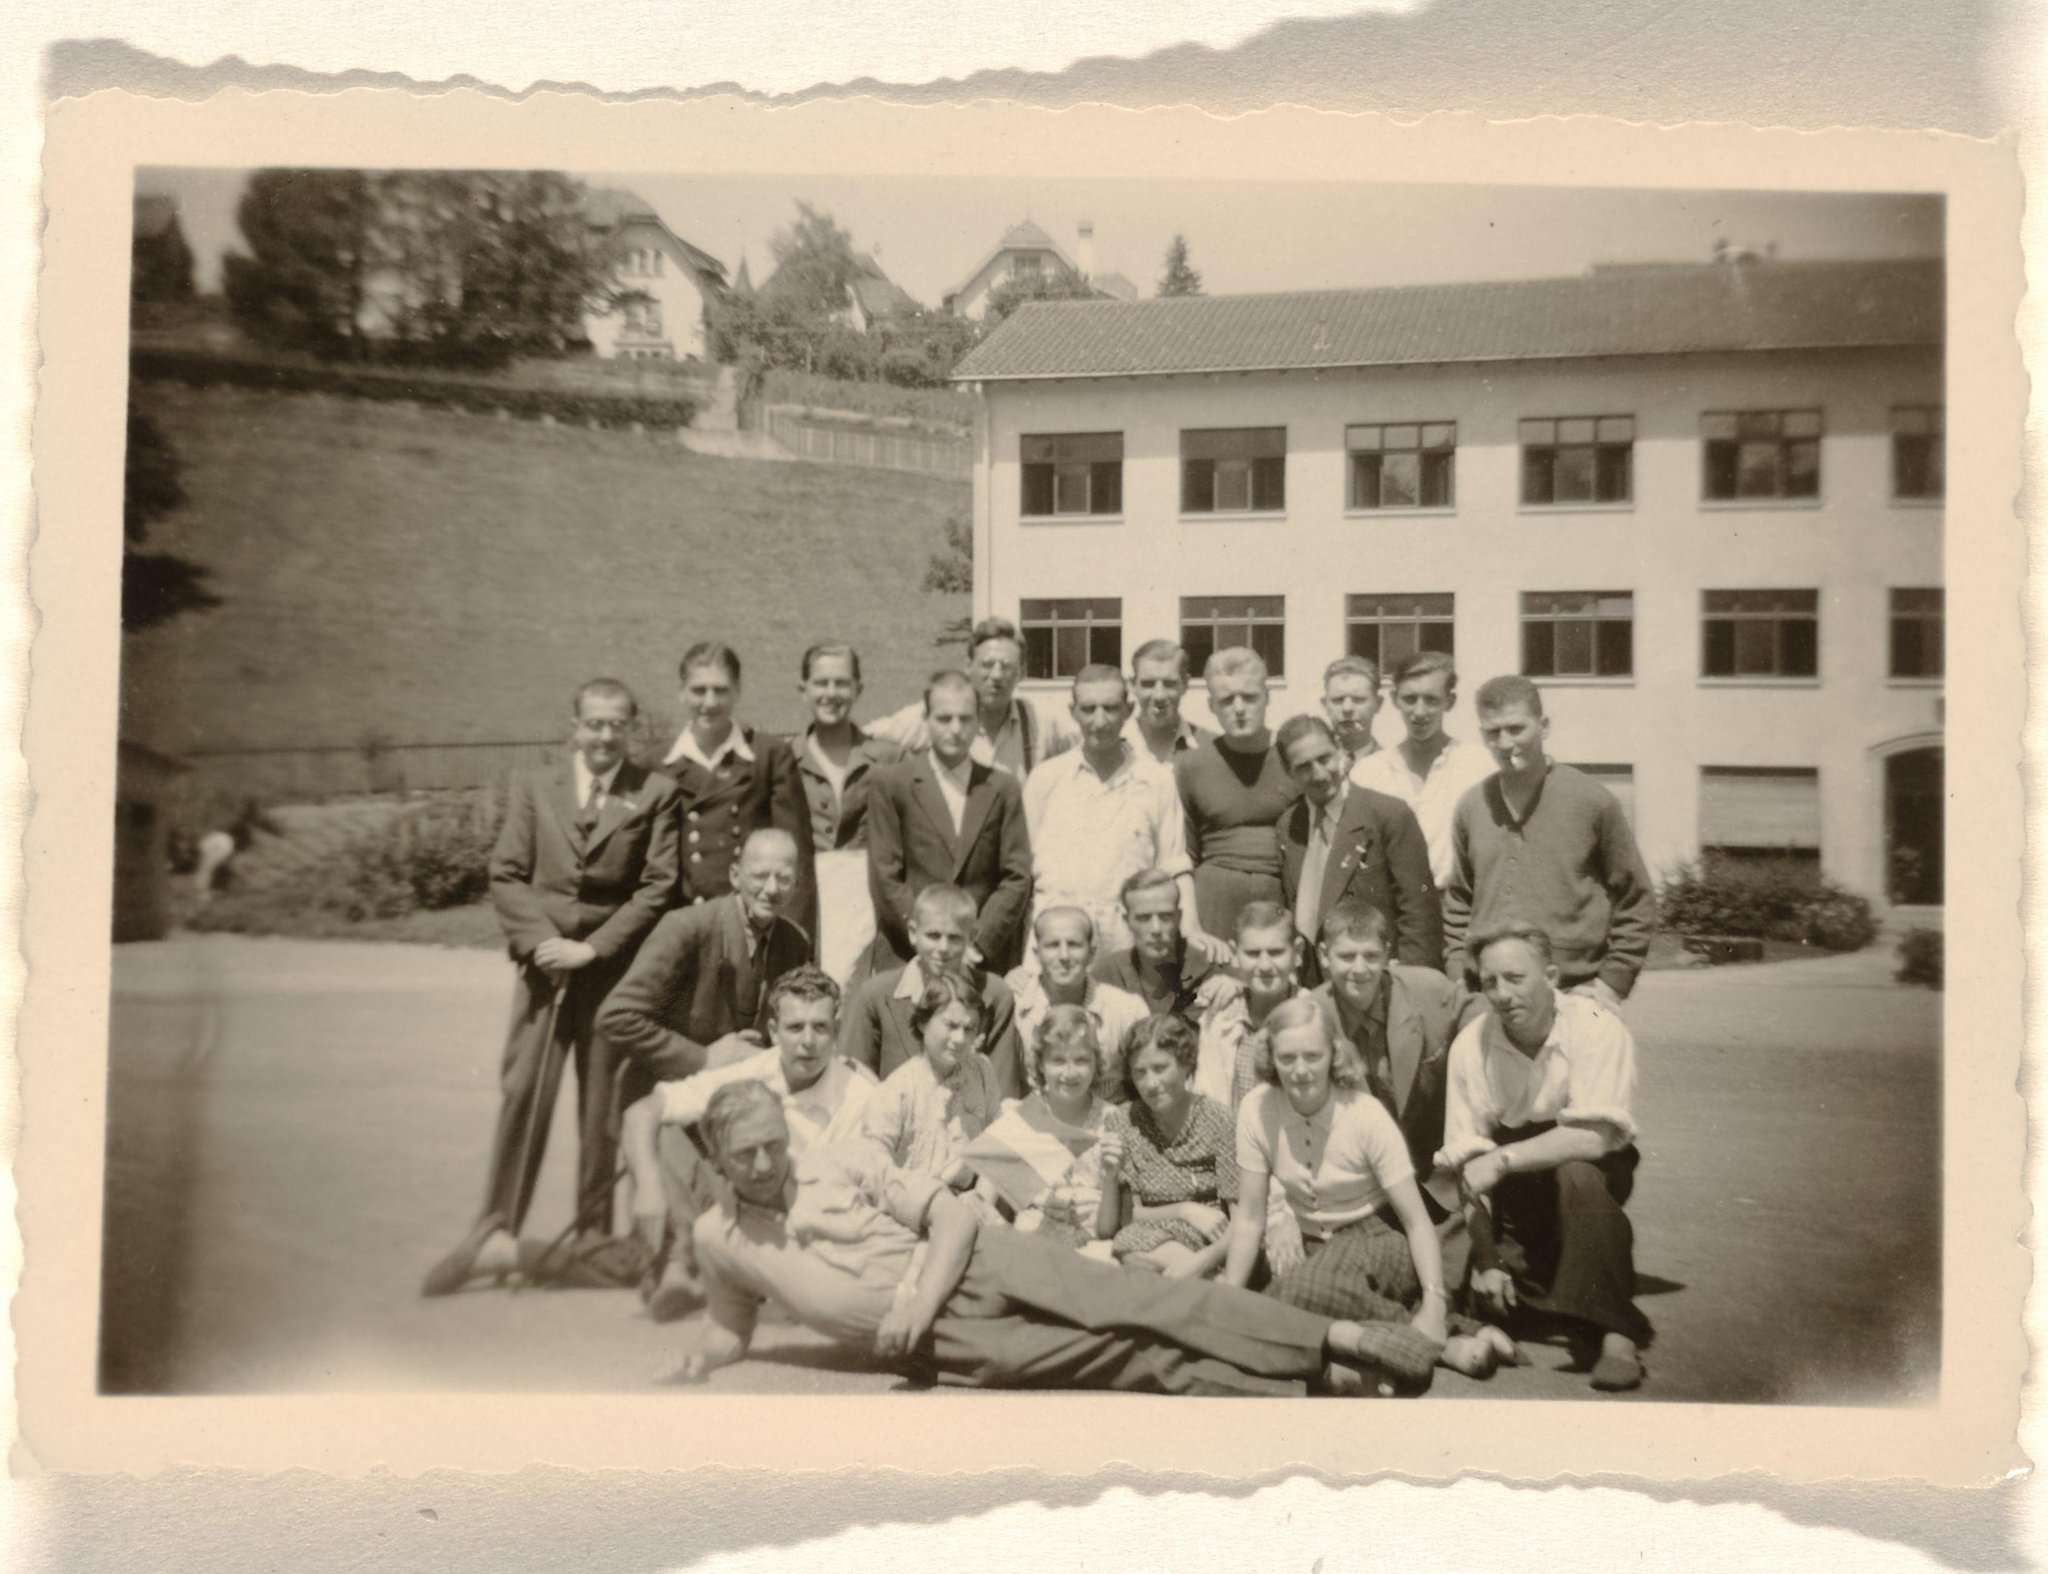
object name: photograph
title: Groepsportret van Nederlandse patiënten uit het ziekenhuis van het Rode Kruis in Herisau, Zwitserland, die samen met Isabel Wachenheimer verbleven in dit ziekenhuis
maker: Anonymous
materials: photographic support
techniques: gelatin silver print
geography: switzerland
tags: leiden, isabel wachenheimer-elon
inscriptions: inscription: ‘Een souvenir van Herisau alle loopende Hollandsche patienten met 3 N.S.Bers Hilde Hamstra’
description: Groepsportret van Nederlandse patiënten uit het ziekenhuis van het Rode Kruis in Herisau, Zwitserland.